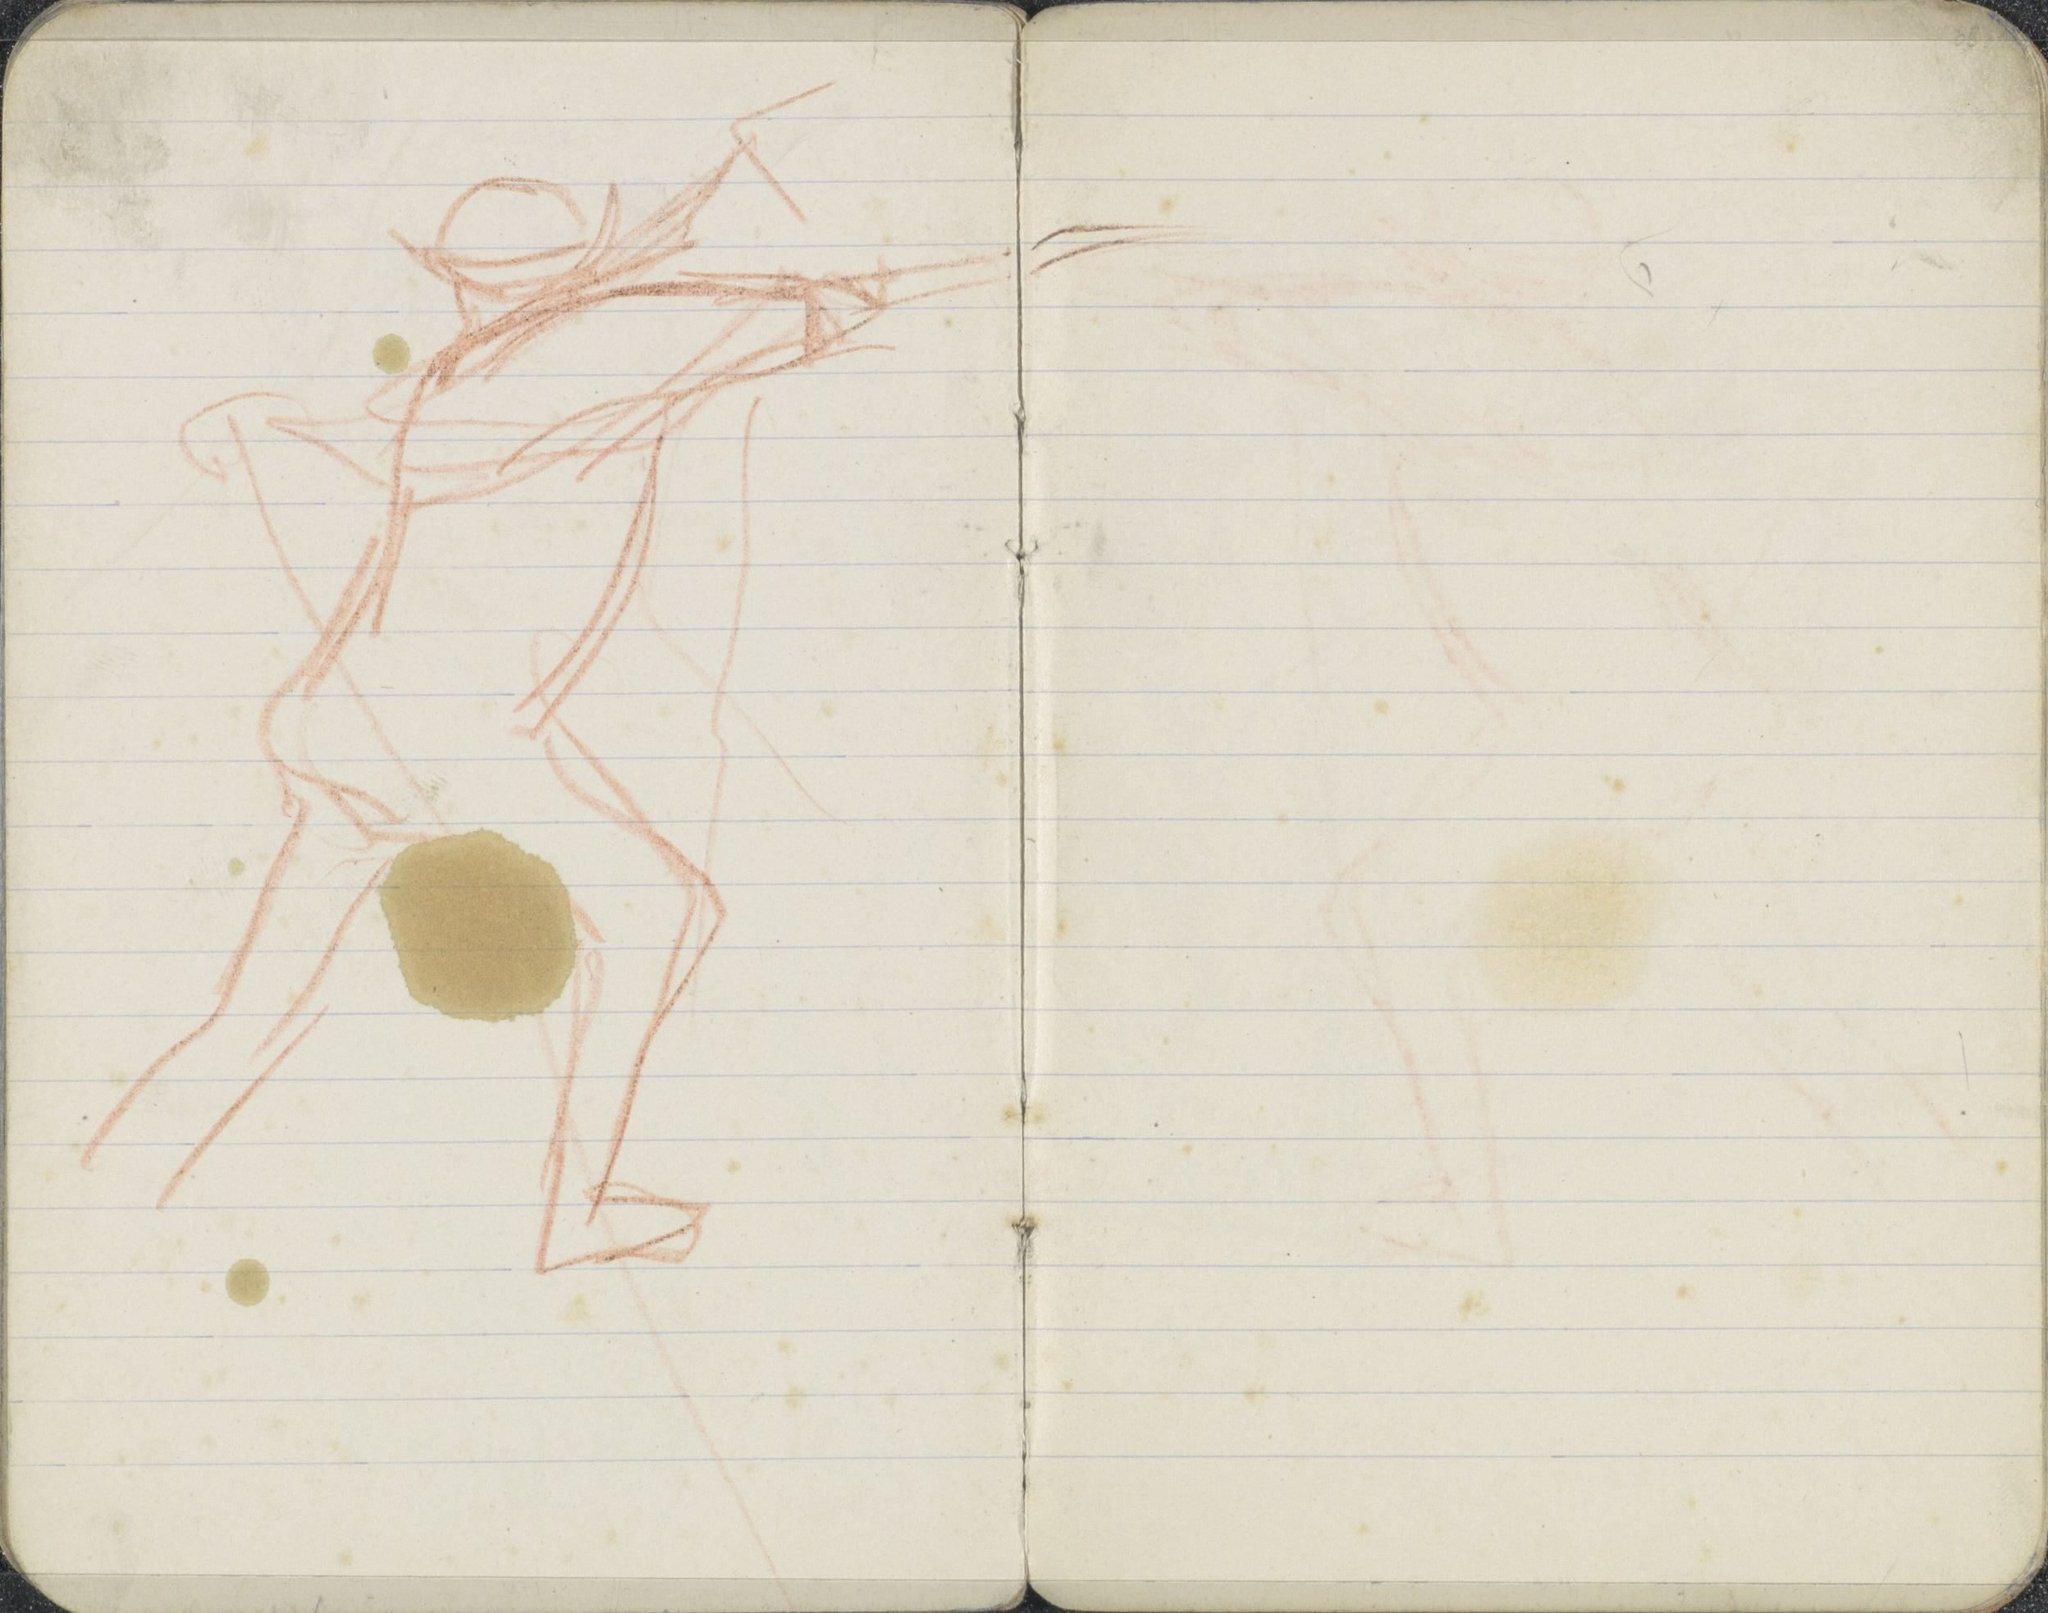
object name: sketchbook leaf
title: Man met hoed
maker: george hendrik breitner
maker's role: draughtsman, painter, print maker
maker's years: 1857-1923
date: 1896-1897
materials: chalk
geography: amsterdam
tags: adult man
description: Pagina 67 en pagina 68 uit een schetsboek met 39 bladen.